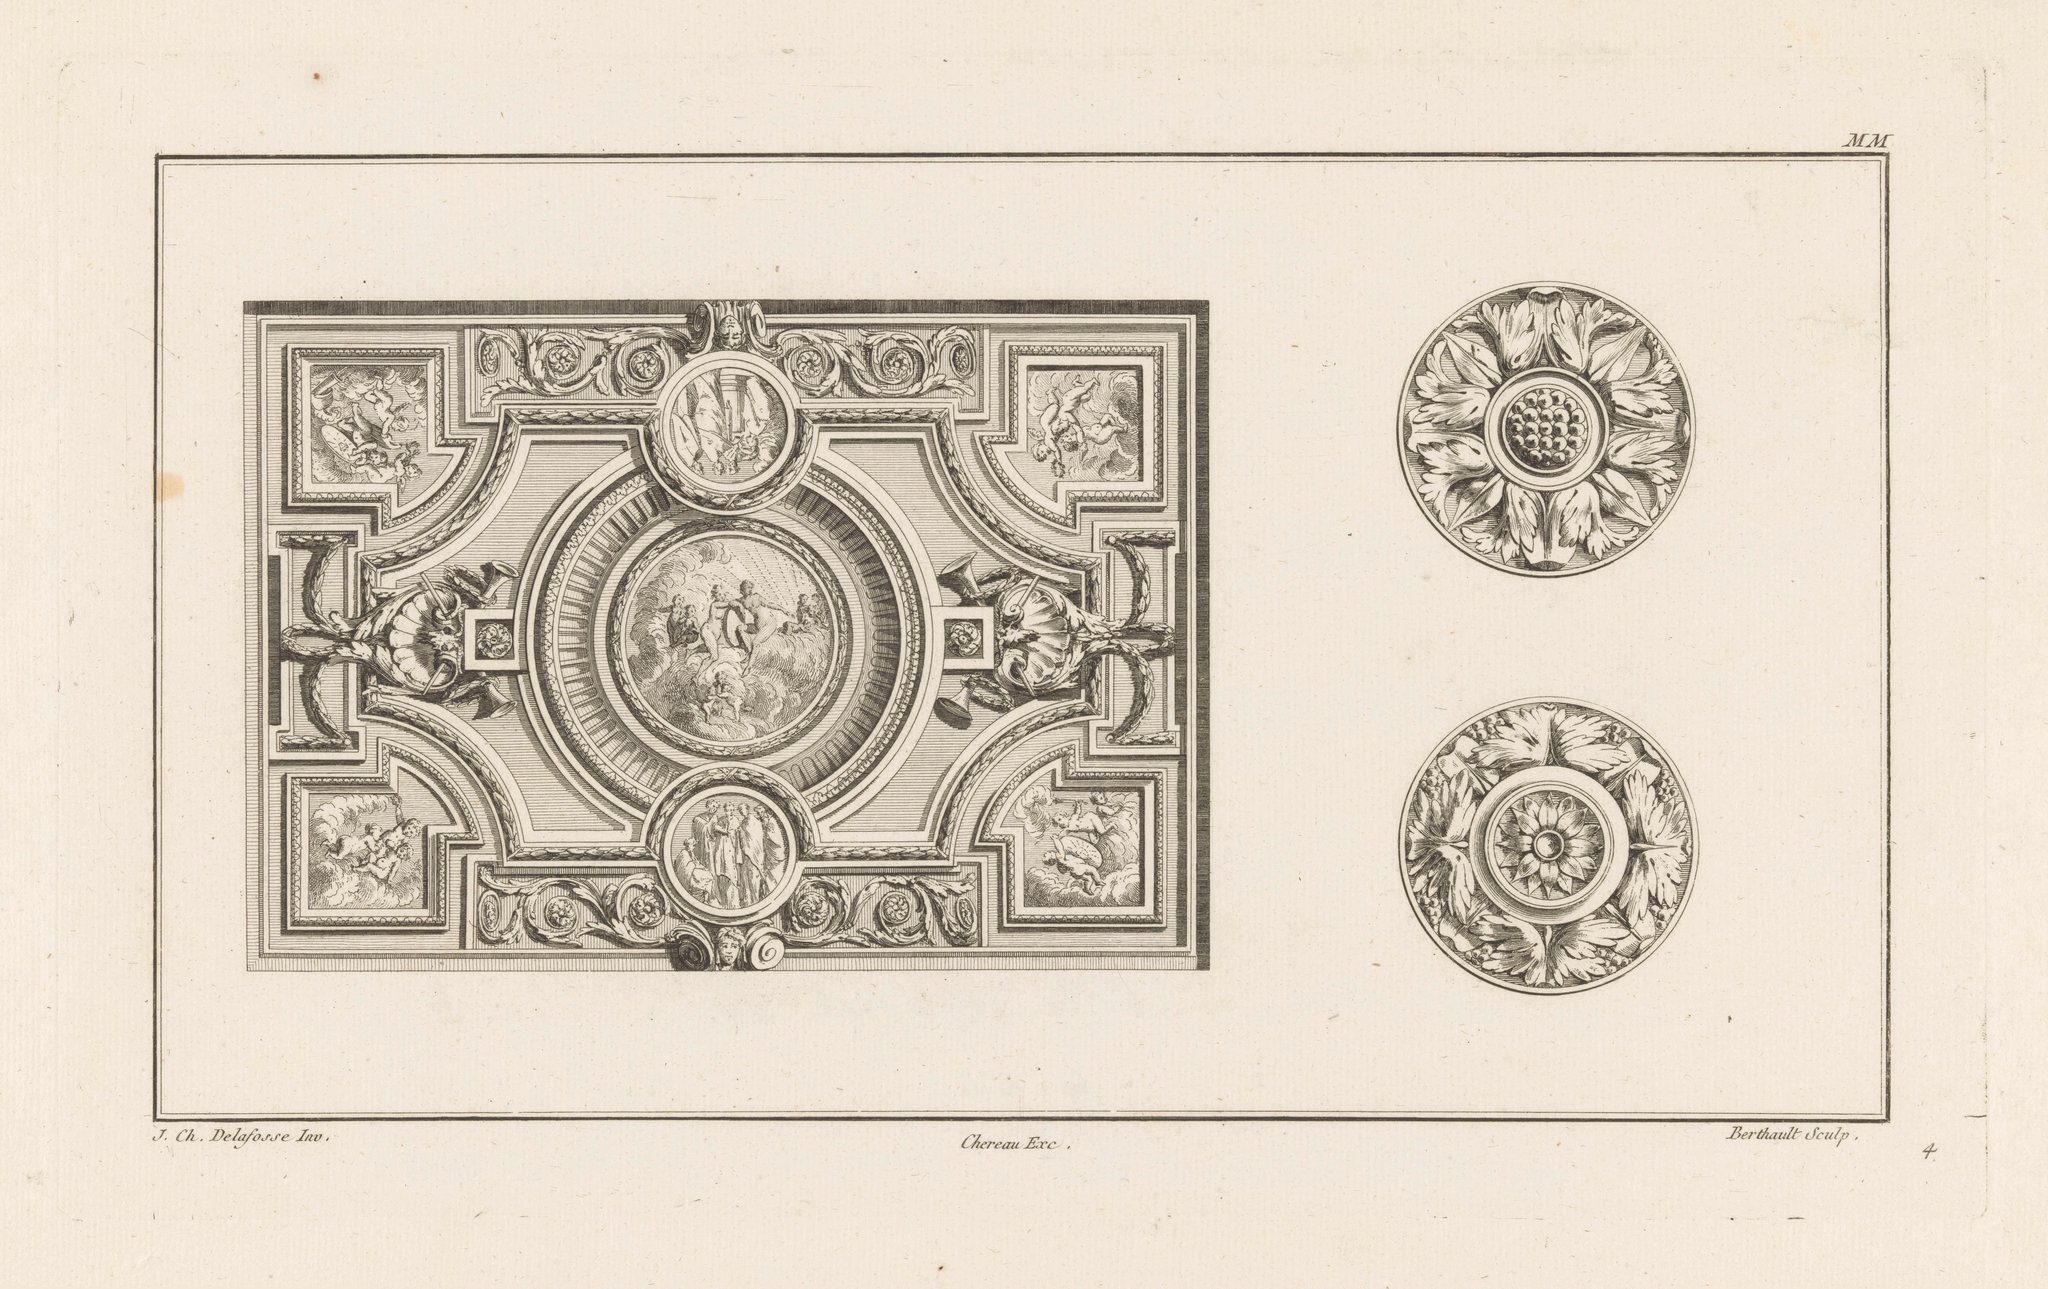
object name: ornament print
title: Plafond en rozetten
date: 1771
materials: paper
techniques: engraving, etching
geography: paris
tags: rosette ~ ornament, (decorated) ceiling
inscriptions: collector's mark: Lugt 2228, collector's mark: Lugt 2760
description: Links een geornamenteerd rechthoekig plafond met putti, schelpmotieven en drie ronde medaillons met figuren. Rechts twee rozetten.